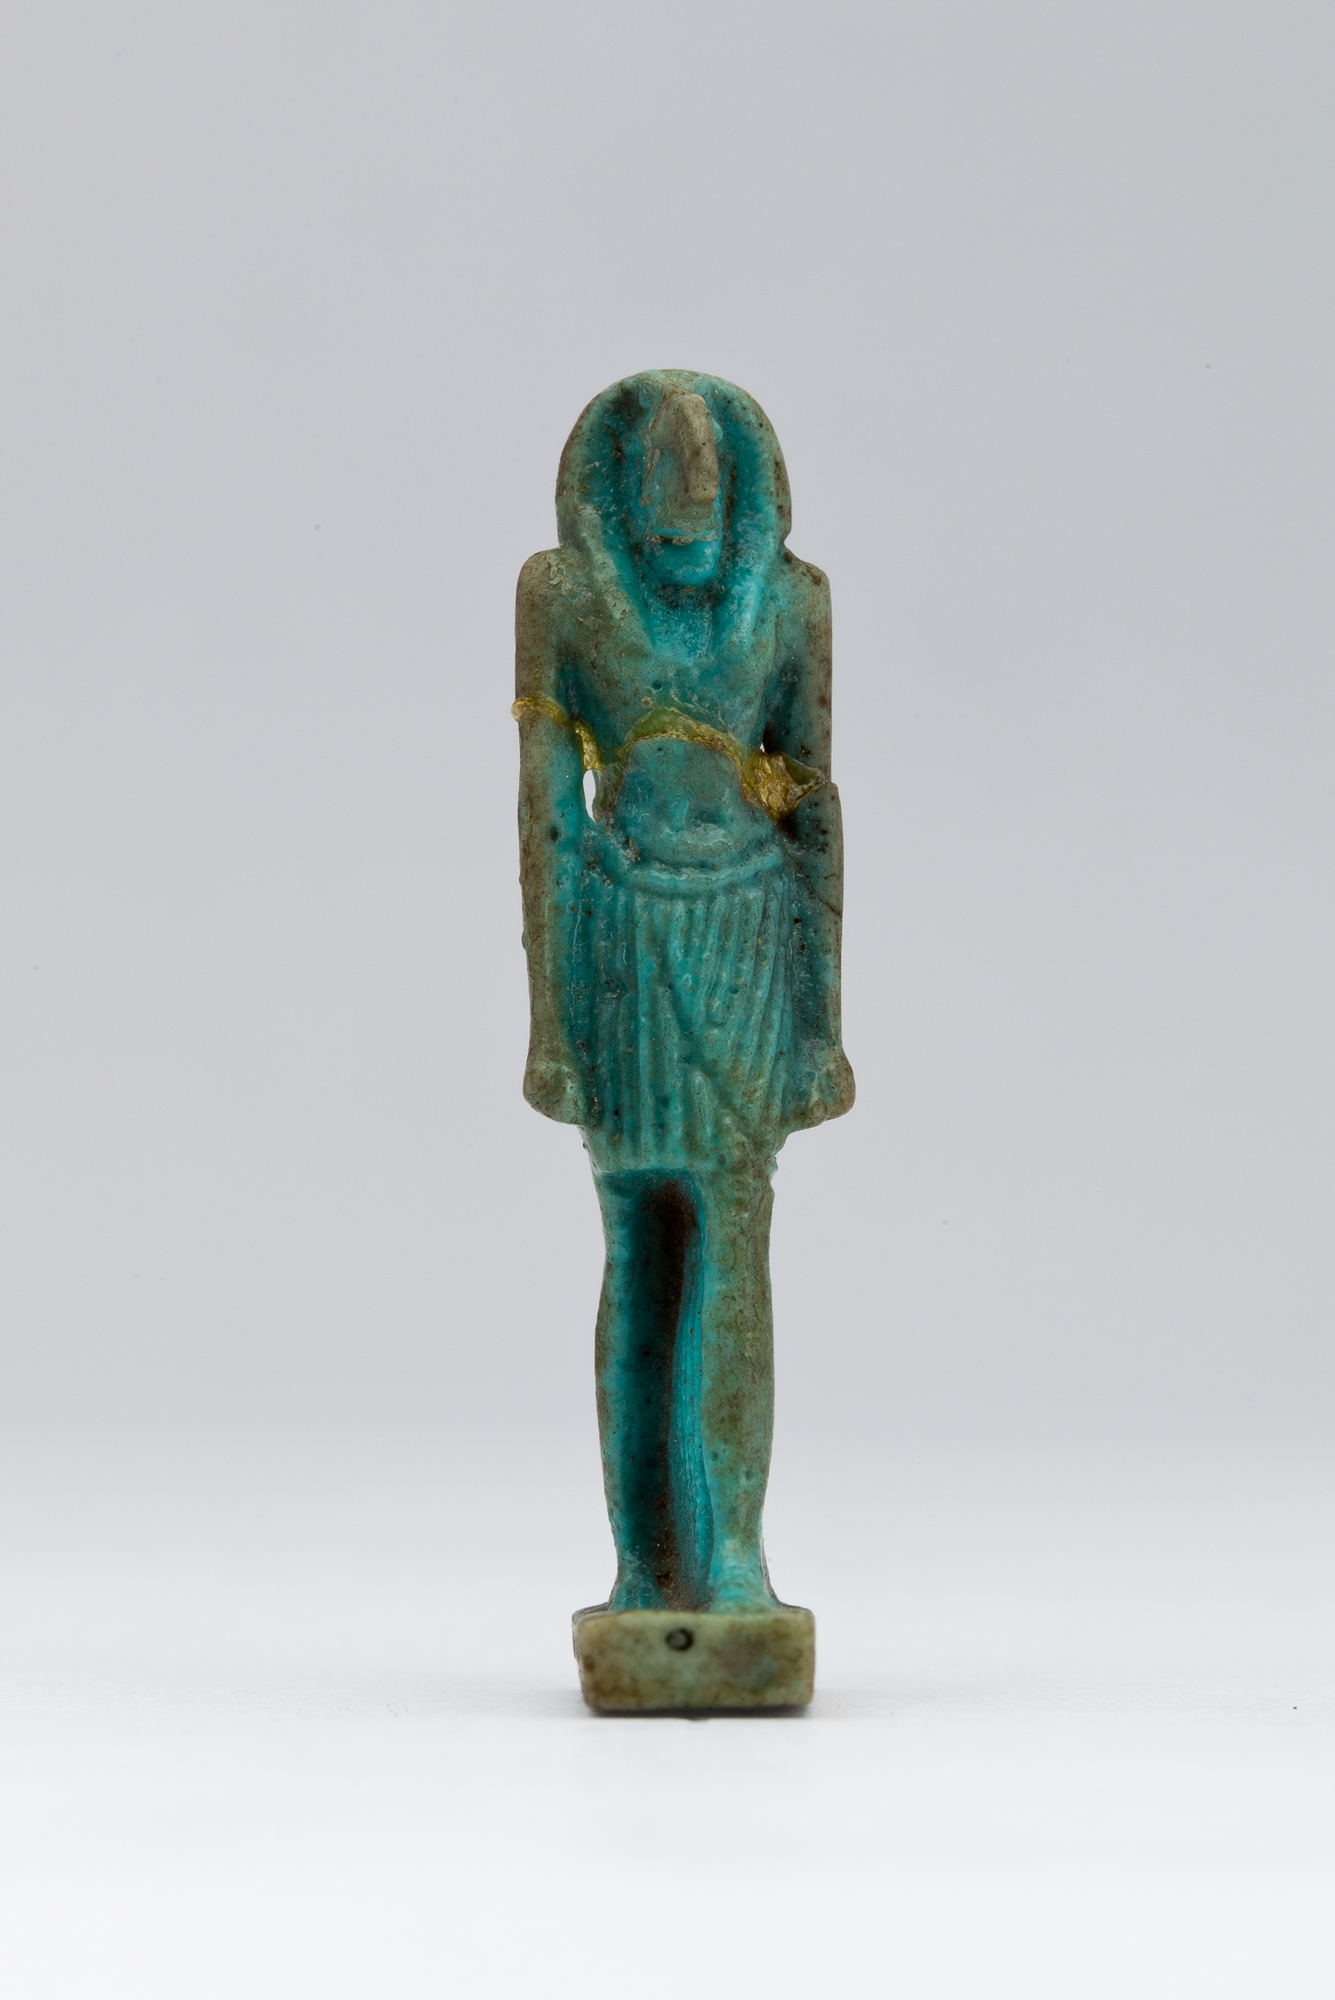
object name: amulet, thoth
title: Thoth Amulet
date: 664-630 BCE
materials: faience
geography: egypt